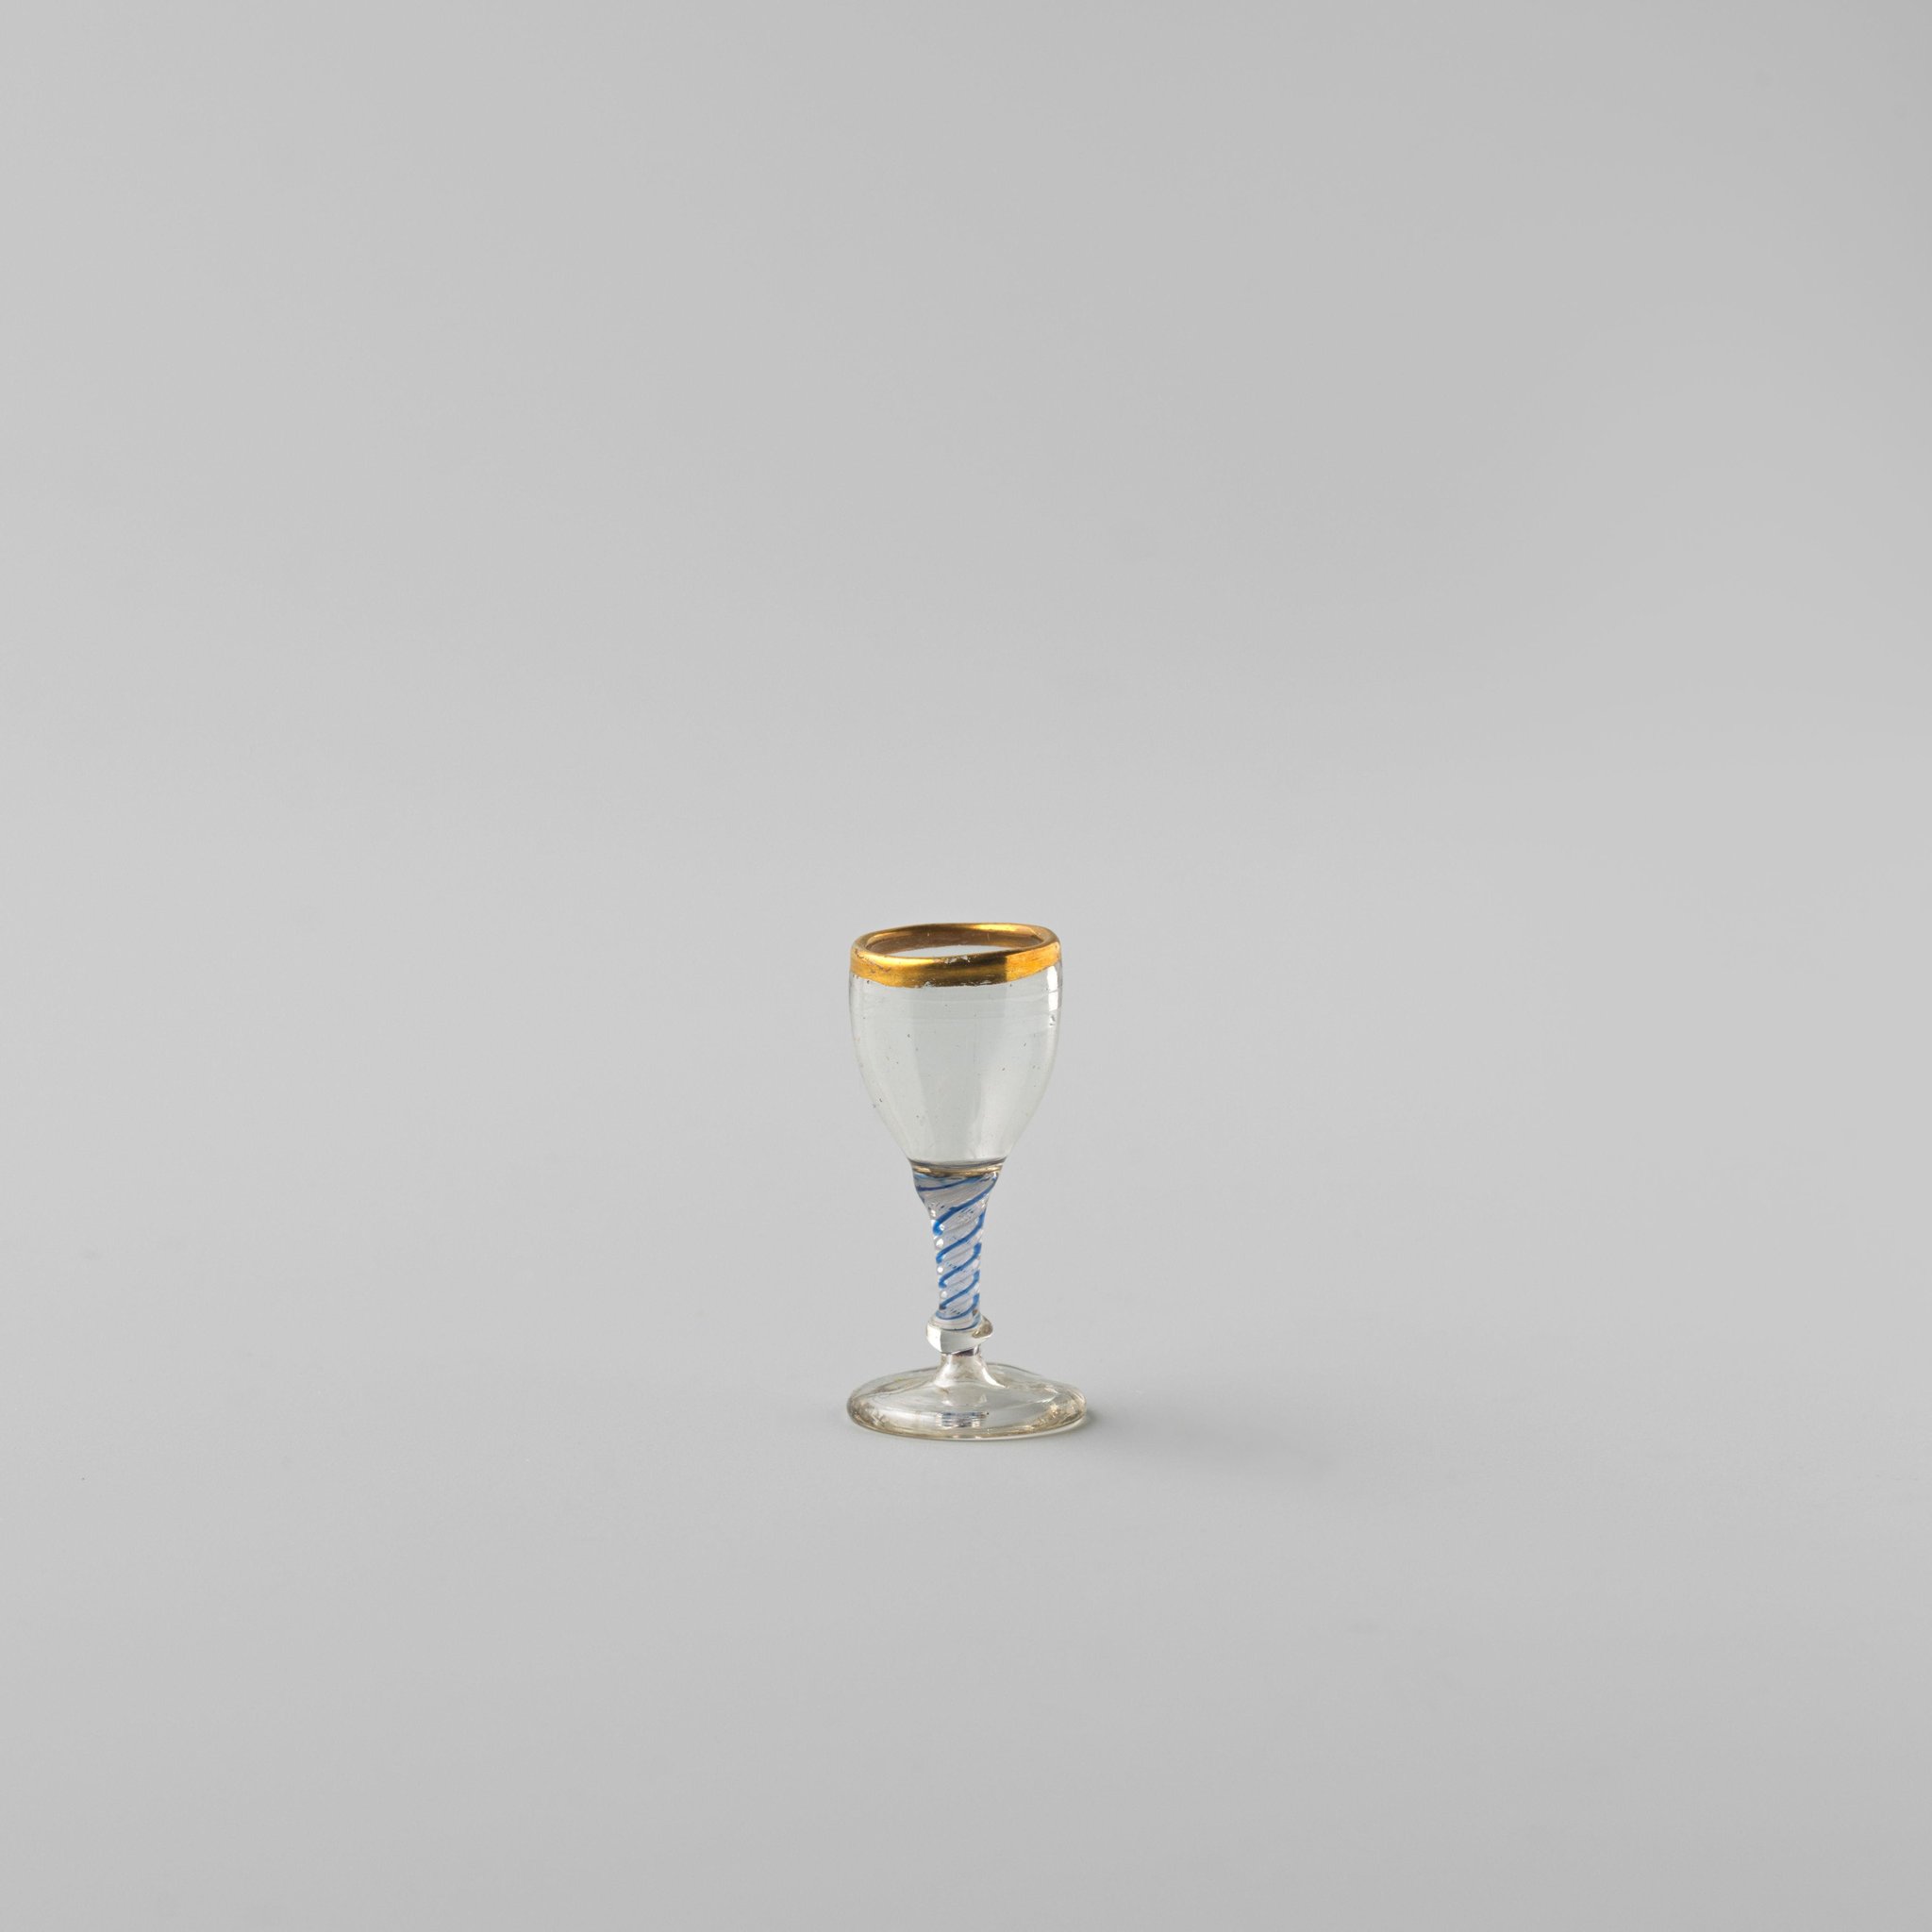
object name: miniature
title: Slingerglas, met stam met witte en blauwe spiralen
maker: Anonymous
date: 1800-1849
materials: glass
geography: bristol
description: Slingerglas van helder, kleurloos glas, eivormige kelk met vergulde mondrand, op stam met opaak witte en blauwe spiralen, met nodus, overgaand in brede platte voet met verdikte rand. Behorend tot een set van zes stuks.